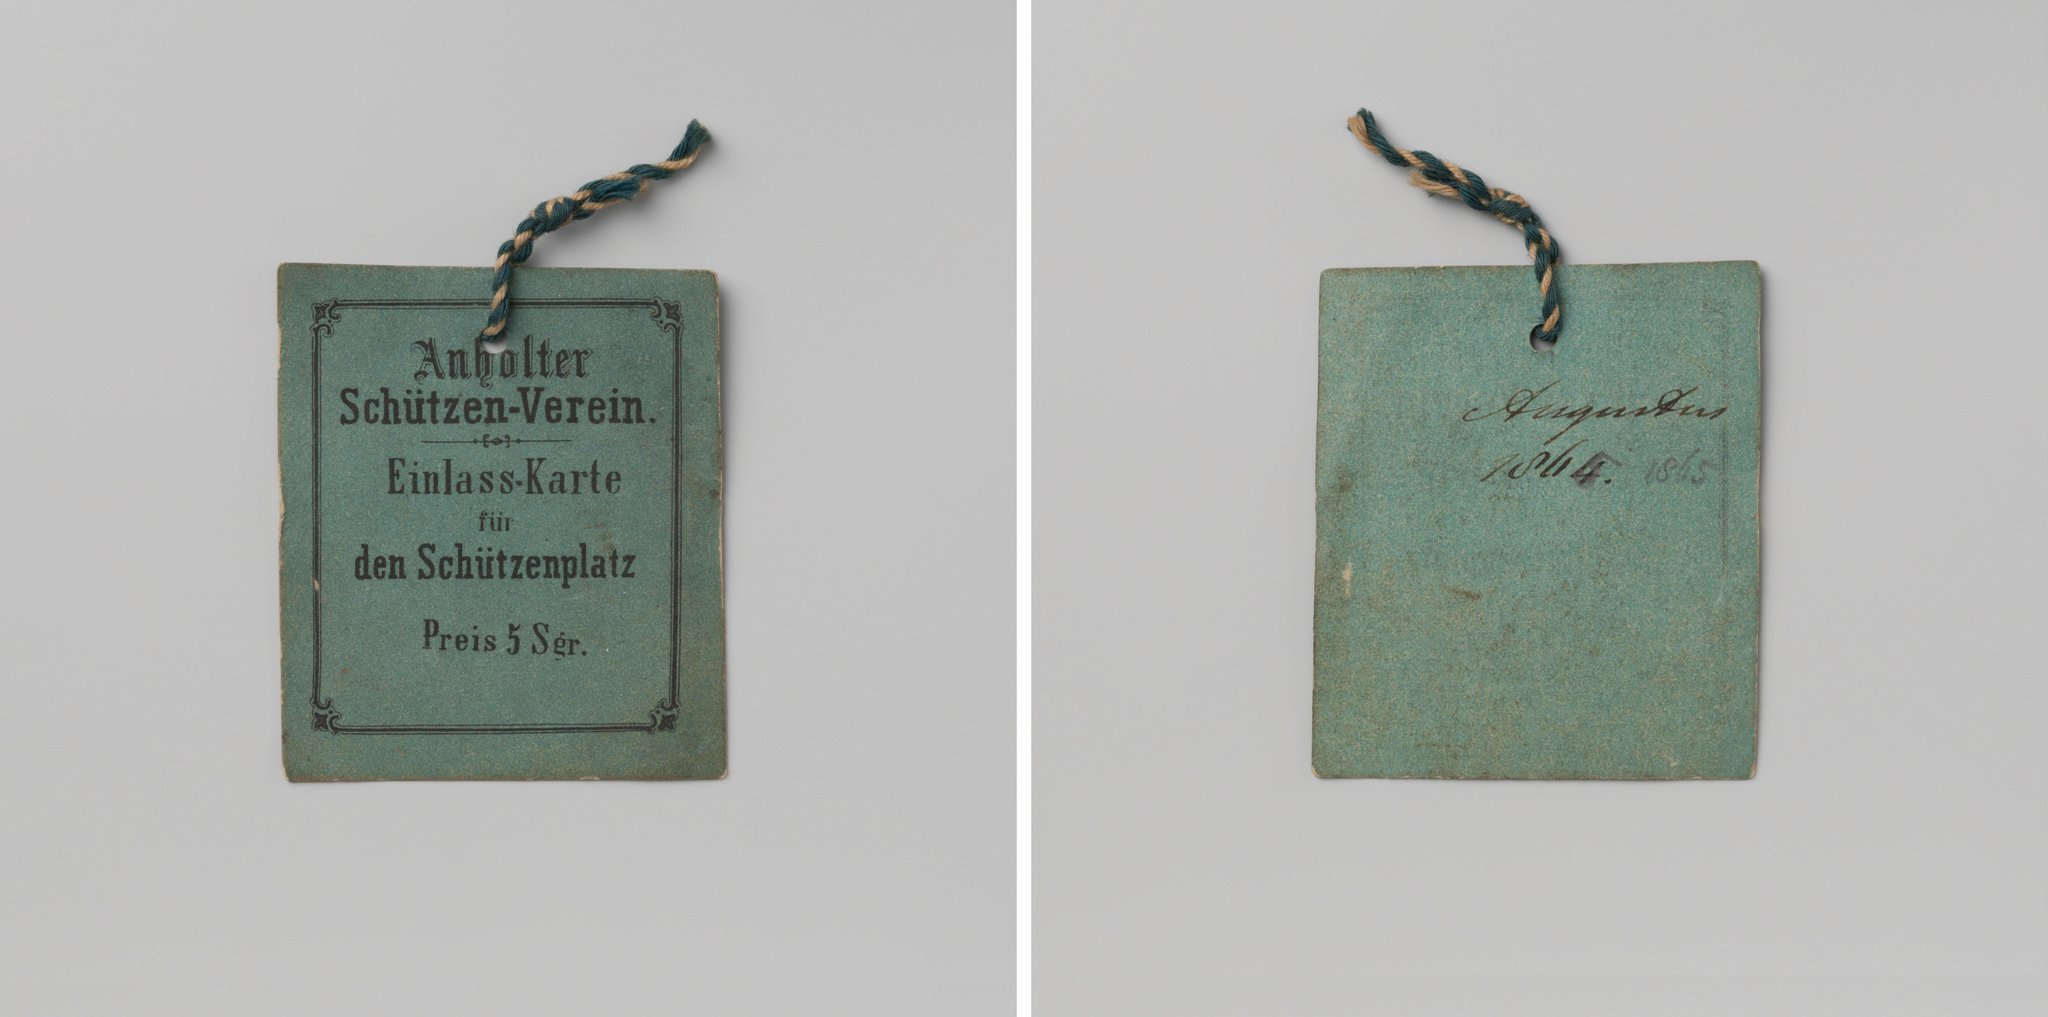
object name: admission ticket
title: Anholter Schützenfest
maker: Anonymous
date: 1865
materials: paper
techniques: printing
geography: germany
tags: anholt